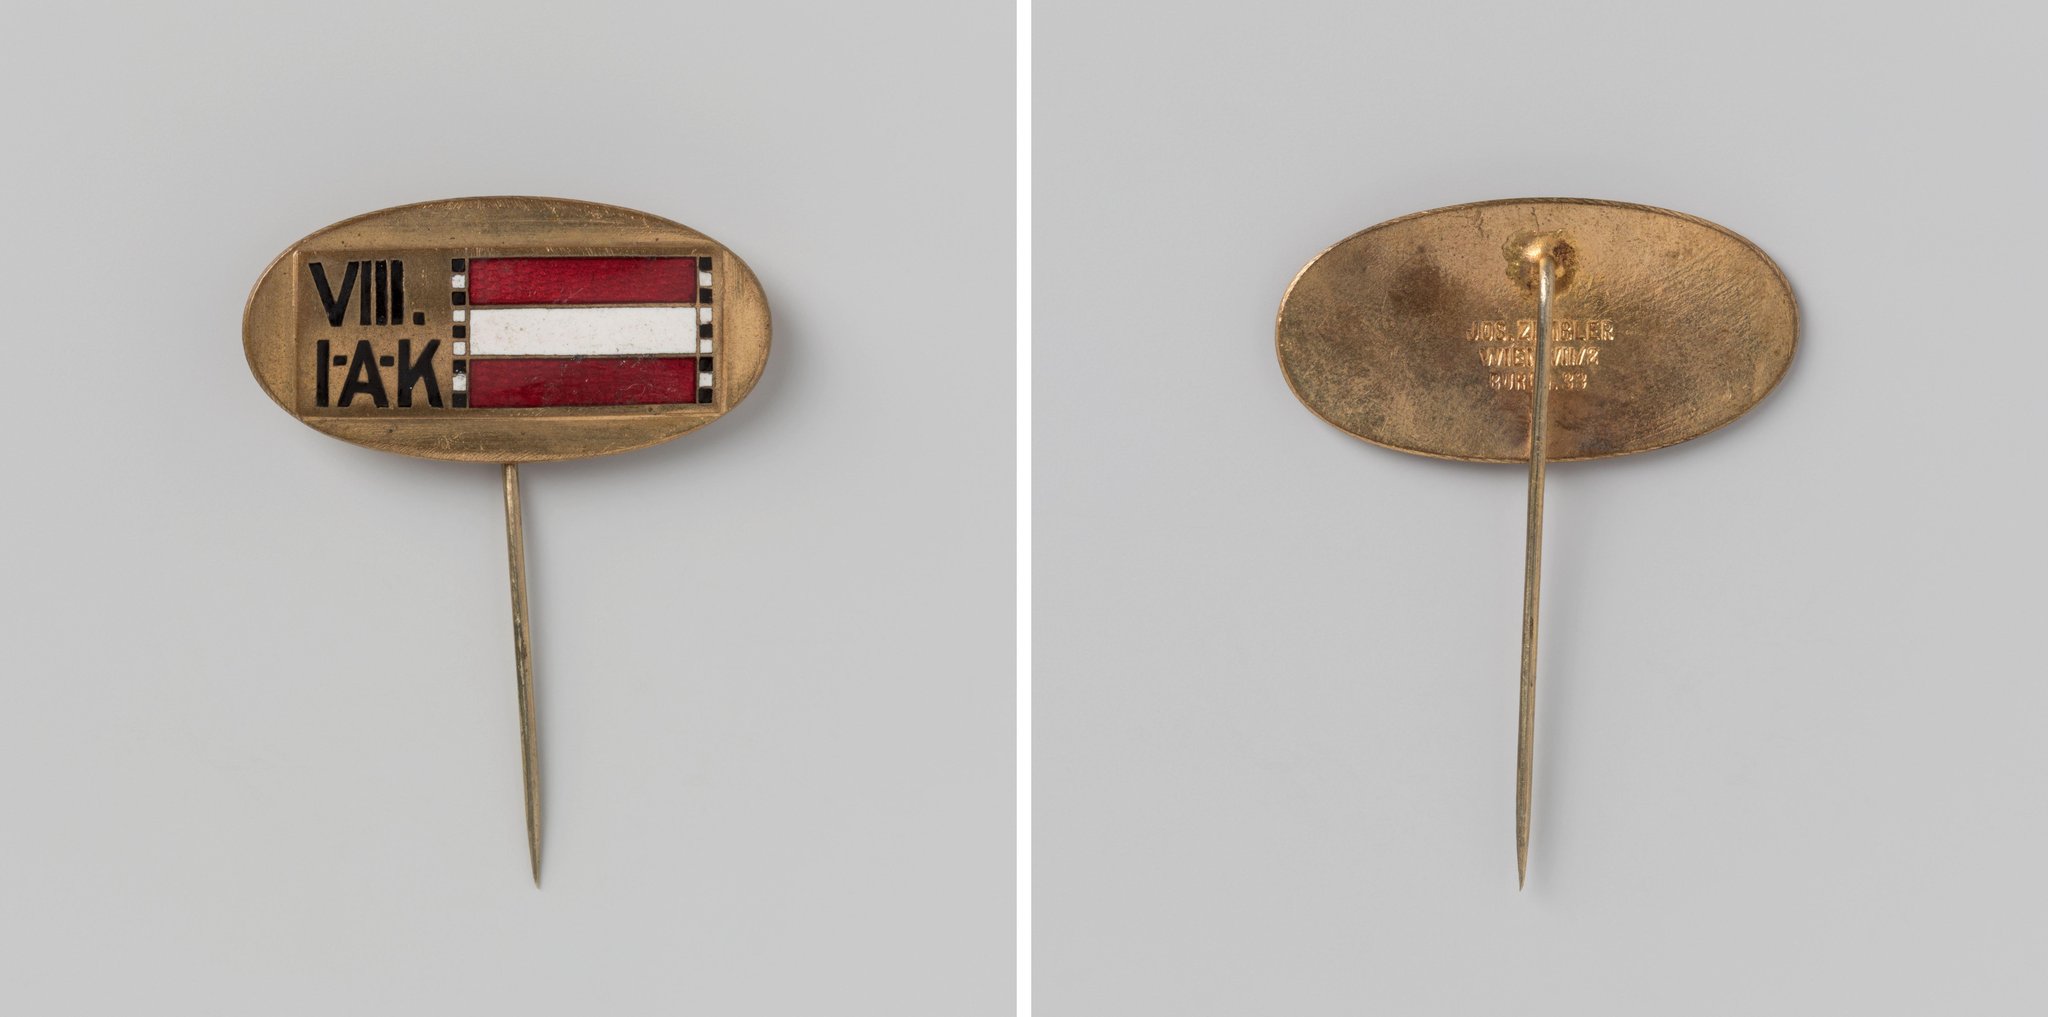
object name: pin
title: VIIIe I.A.K. (8e Internationaler Architekten Kongress)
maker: jos. zimbler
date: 1908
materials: copper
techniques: striking, welding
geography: vienna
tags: vienna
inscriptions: inscription: ‘VIII . I - A - K’, signature: ‘JOS ZIMBLER WIEN VII / 2 BURGR.38.’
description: Eenzijdig ovaal plaatje aan gebogen speld. Voorzijde: op rechthoekig veld: links opschrift, rechts drie horizontale banen in kleuren rood, wit en rood (Oostenrijkse vlag); aan linker- en rechterzijde ervan randje van afwisselend zwarte en witte vierkantjes. Keerzijde: opschrift.